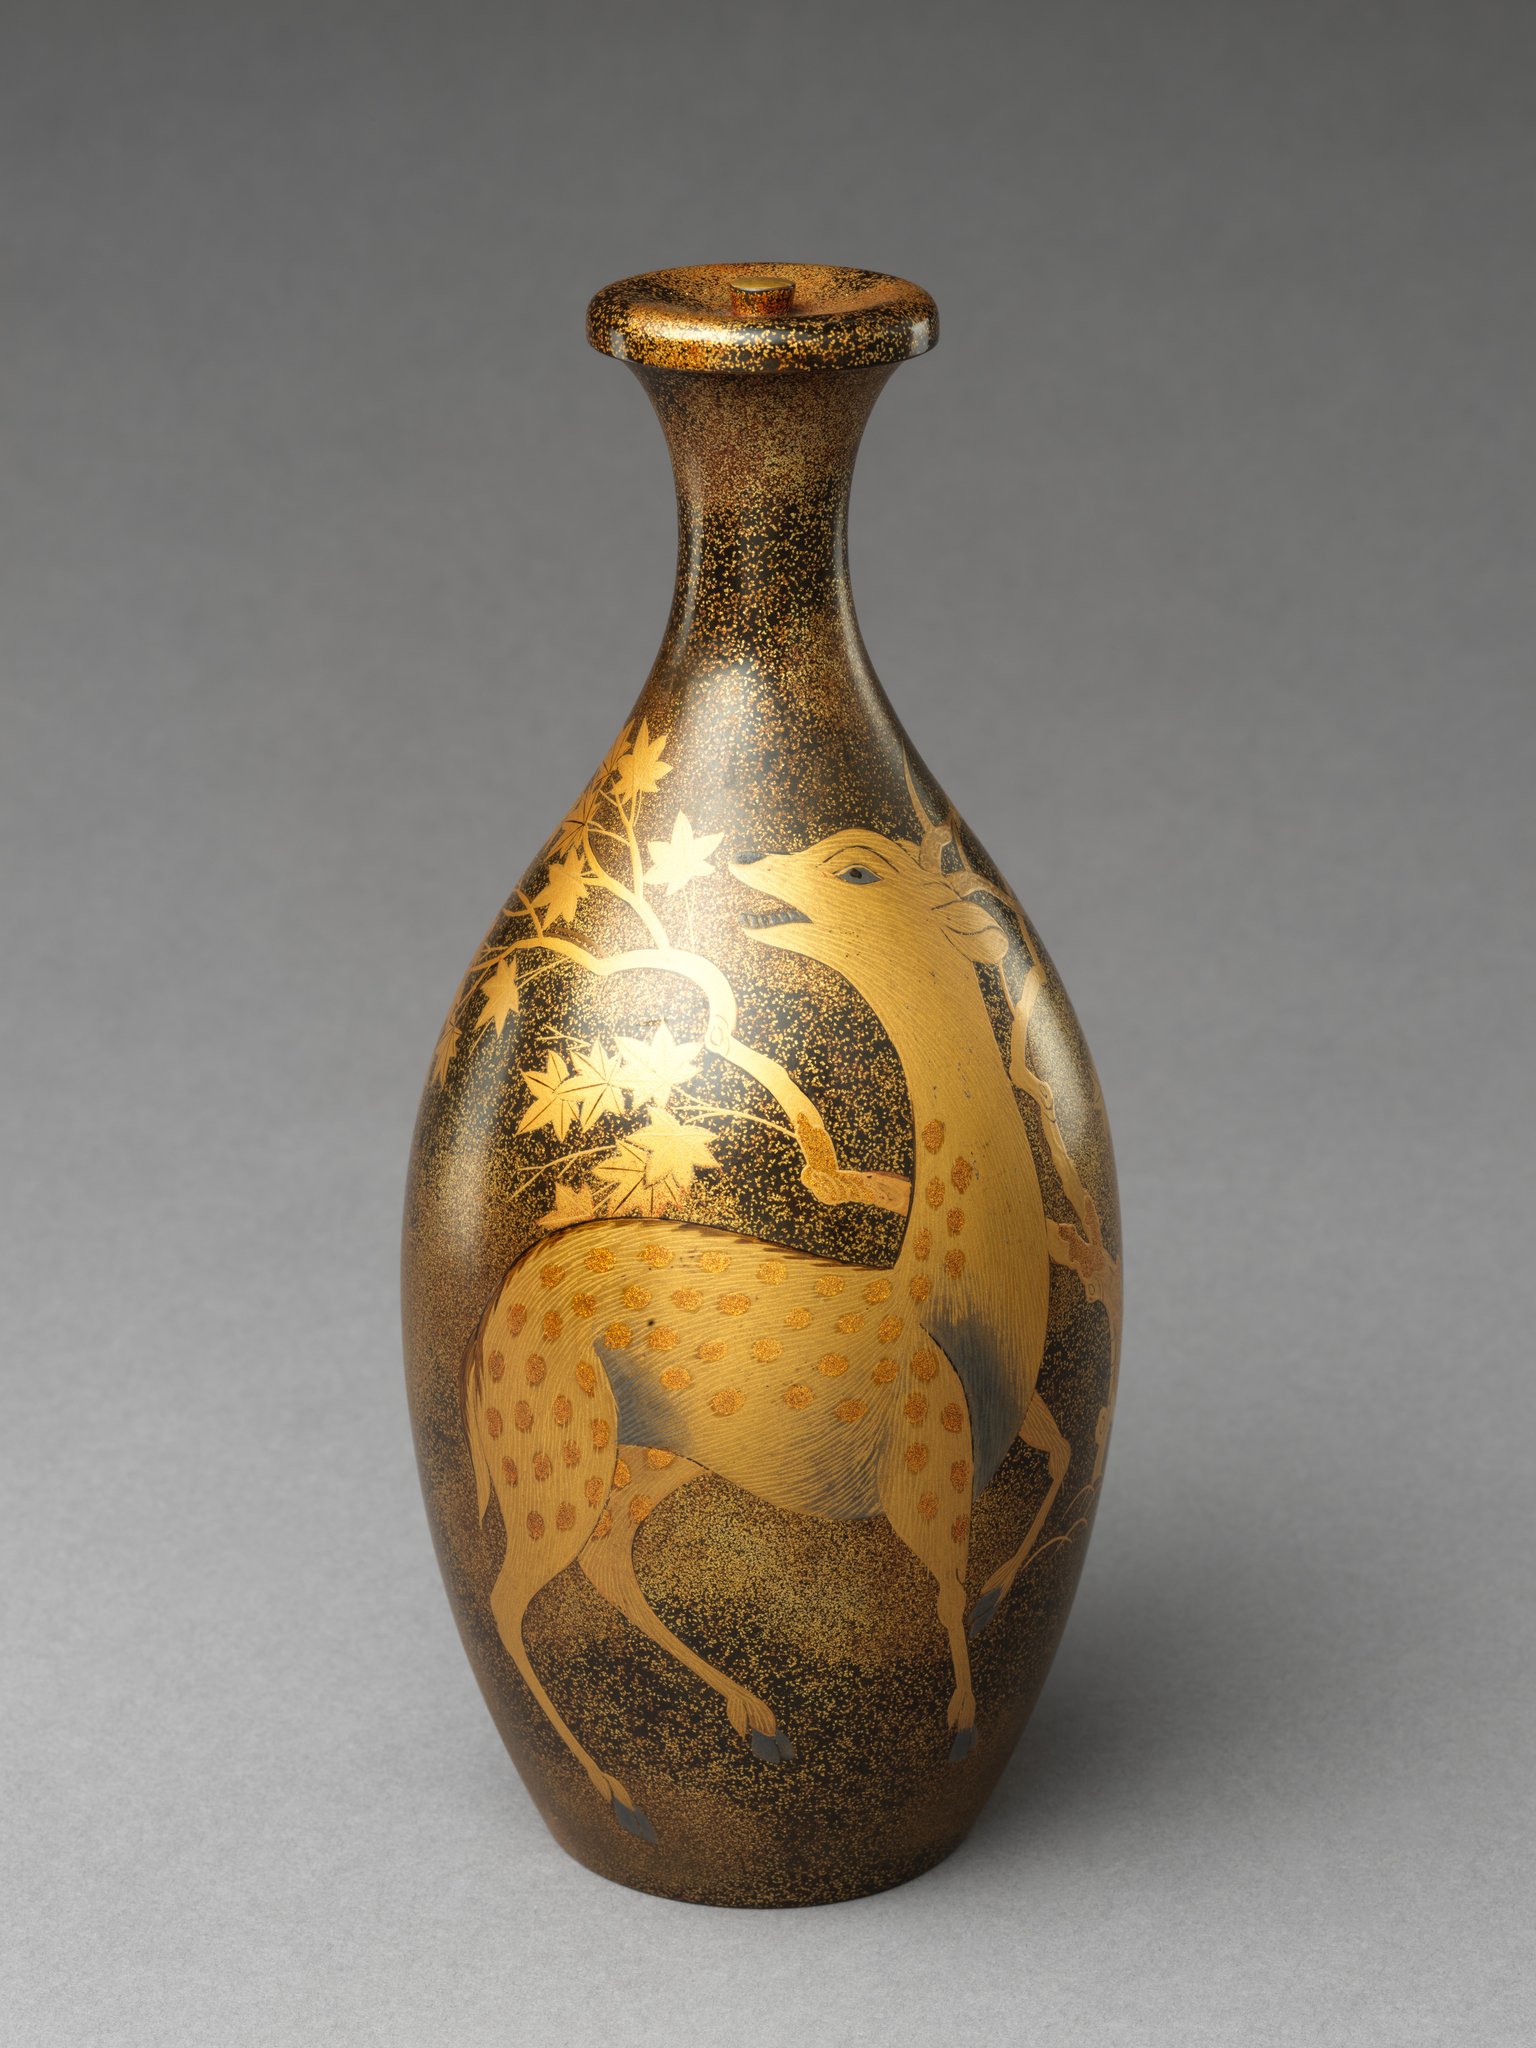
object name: sake bottle one of a pair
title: Sake bottle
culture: japanese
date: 1573-1615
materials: gold, lacquer, silver